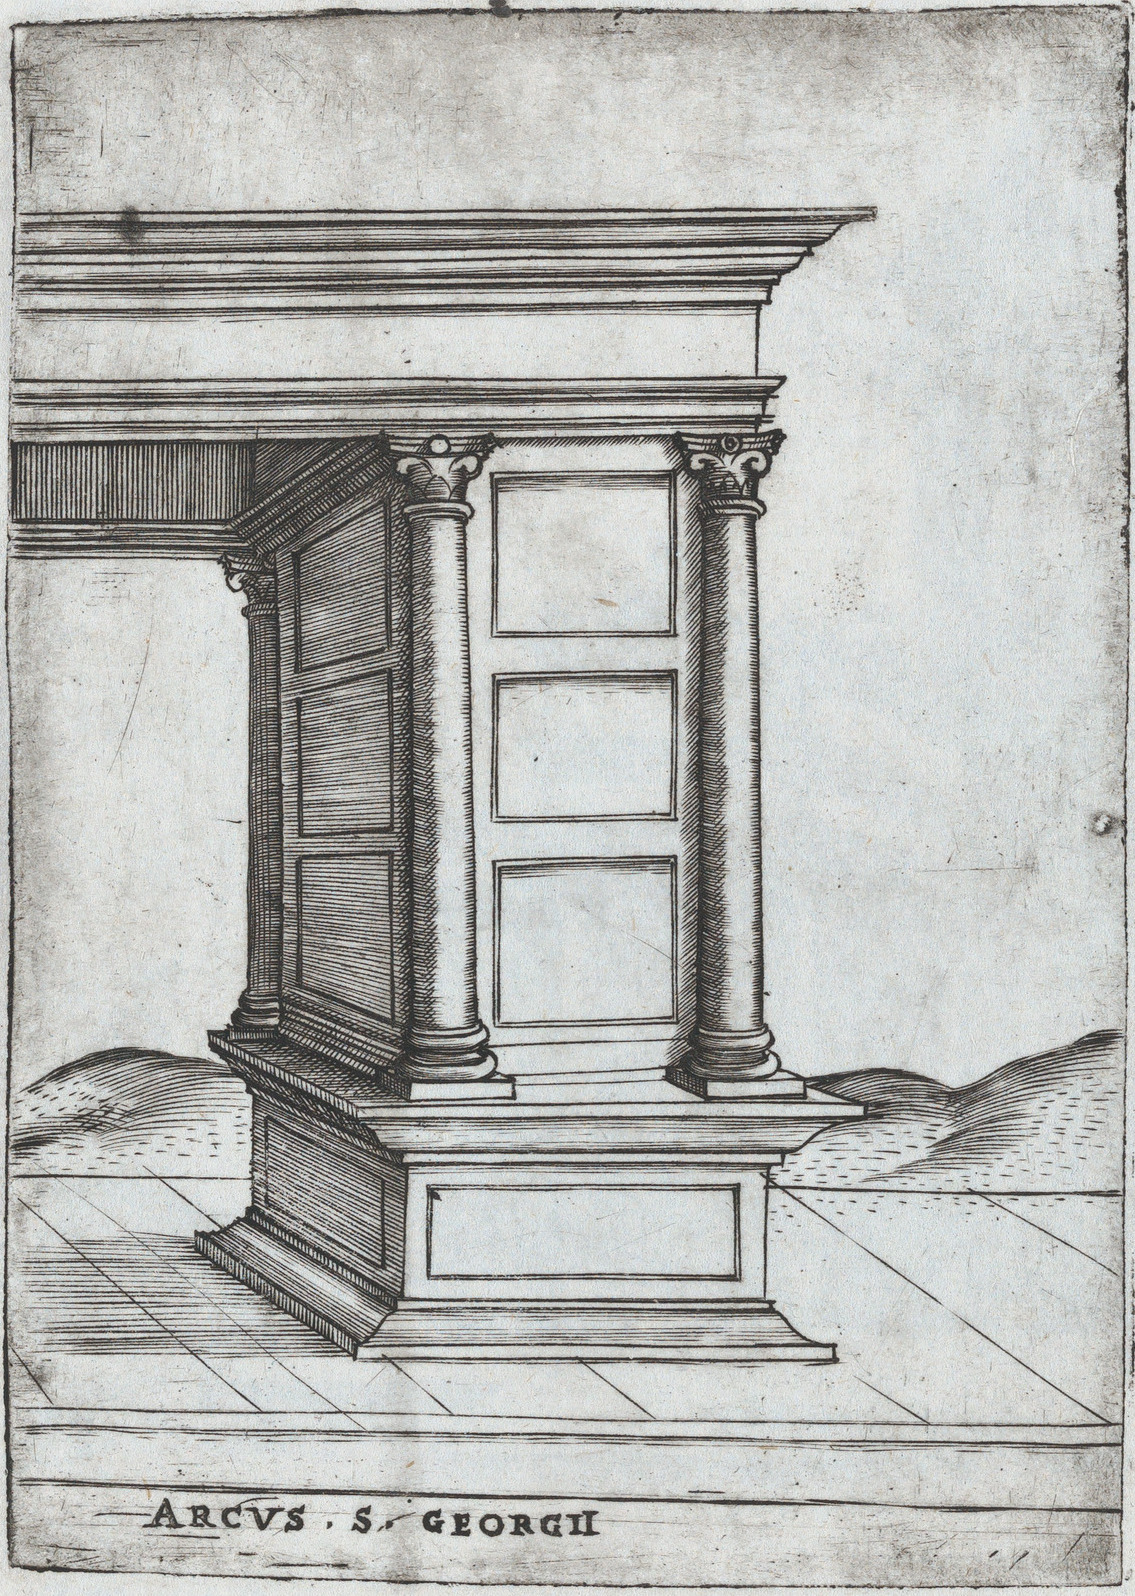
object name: album print ornament architecture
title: Arcus in Provincia, from a Series of Prints depicting (reconstructed) Buildings from Roman Antiquity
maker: monogrammist g.a. with the caltrop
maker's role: artist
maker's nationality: italian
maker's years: 1535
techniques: engraving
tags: architecture